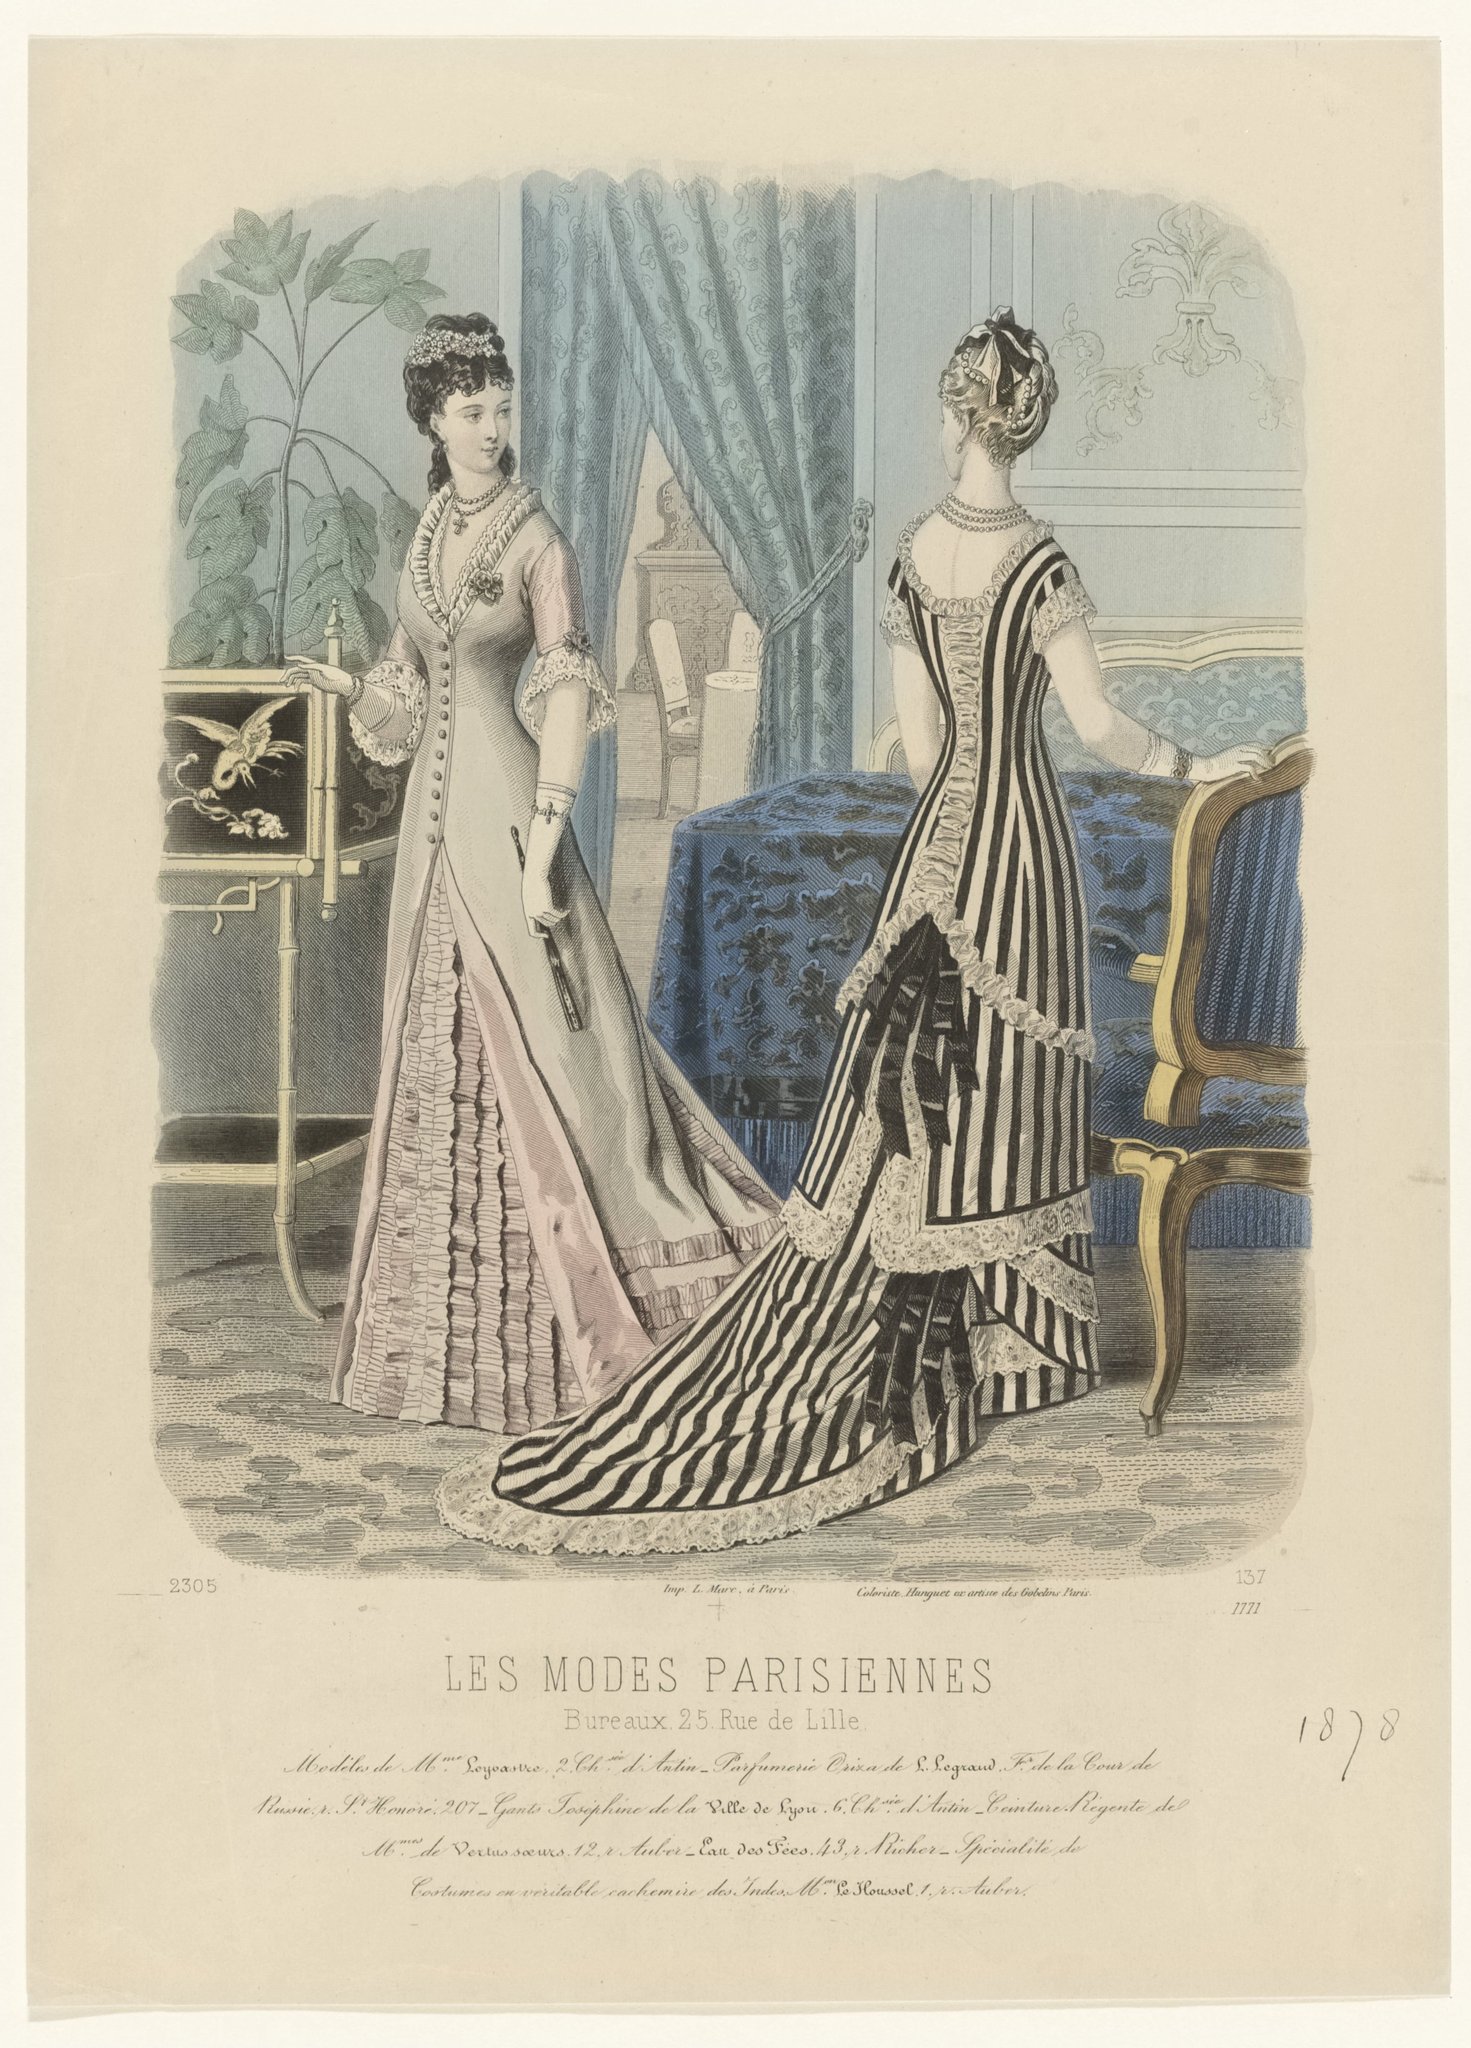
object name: fashion print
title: Les Modes Parisiennes, 1878, No. 1771 : Modèles de Mme Leyvastr (...)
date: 1878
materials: paper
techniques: engraving, hand coloring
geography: paris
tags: corsage (+ women's clothes), curtains, pendant, trinket, 'breloque' (+ women's clothes), dress, gown: evening dress (+ women's clothes), gloves, mittens (long gloves) (+ women's clothes), border, ribbon, braid (+ women's clothes), fashion plates, fan (+ women's clothes), bracelet, wristlet (+ women's clothes)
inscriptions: title: ‘LES MODES PARISIENNES’, address: ‘Bureaux, 25, Rue de Lille’, caption: ‘Modéles de Mme Leyvastre, 2, Ch.sée d'Antin_Parfumerie Oriza de L.Legrand. F.r de la Cour de Russie.r. S.t Honoré, 207_Gants Joséphine de la Ville de Lyon, 6, Ch.sée d'Antin_ Ceinture-Régente de Mmes de Vertus soeurs,12,r Auber_ Eau des Fées, 43,r, Richer_Spécialité de Costumes en véritable cachemire des Indes, M.on Le Houssel, 1, r. Auber’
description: Twee vrouwen in een interieur, van wie één in een verticaal gestreepte avondjapon met sleep. Volgens het onderschrift: 'modèles' van Leyvastre. Hieronder enkele regels reclametekst voor verschillende producten. Prent uit het modetijdschrift Les Modes Parisiennes (1843-1885).